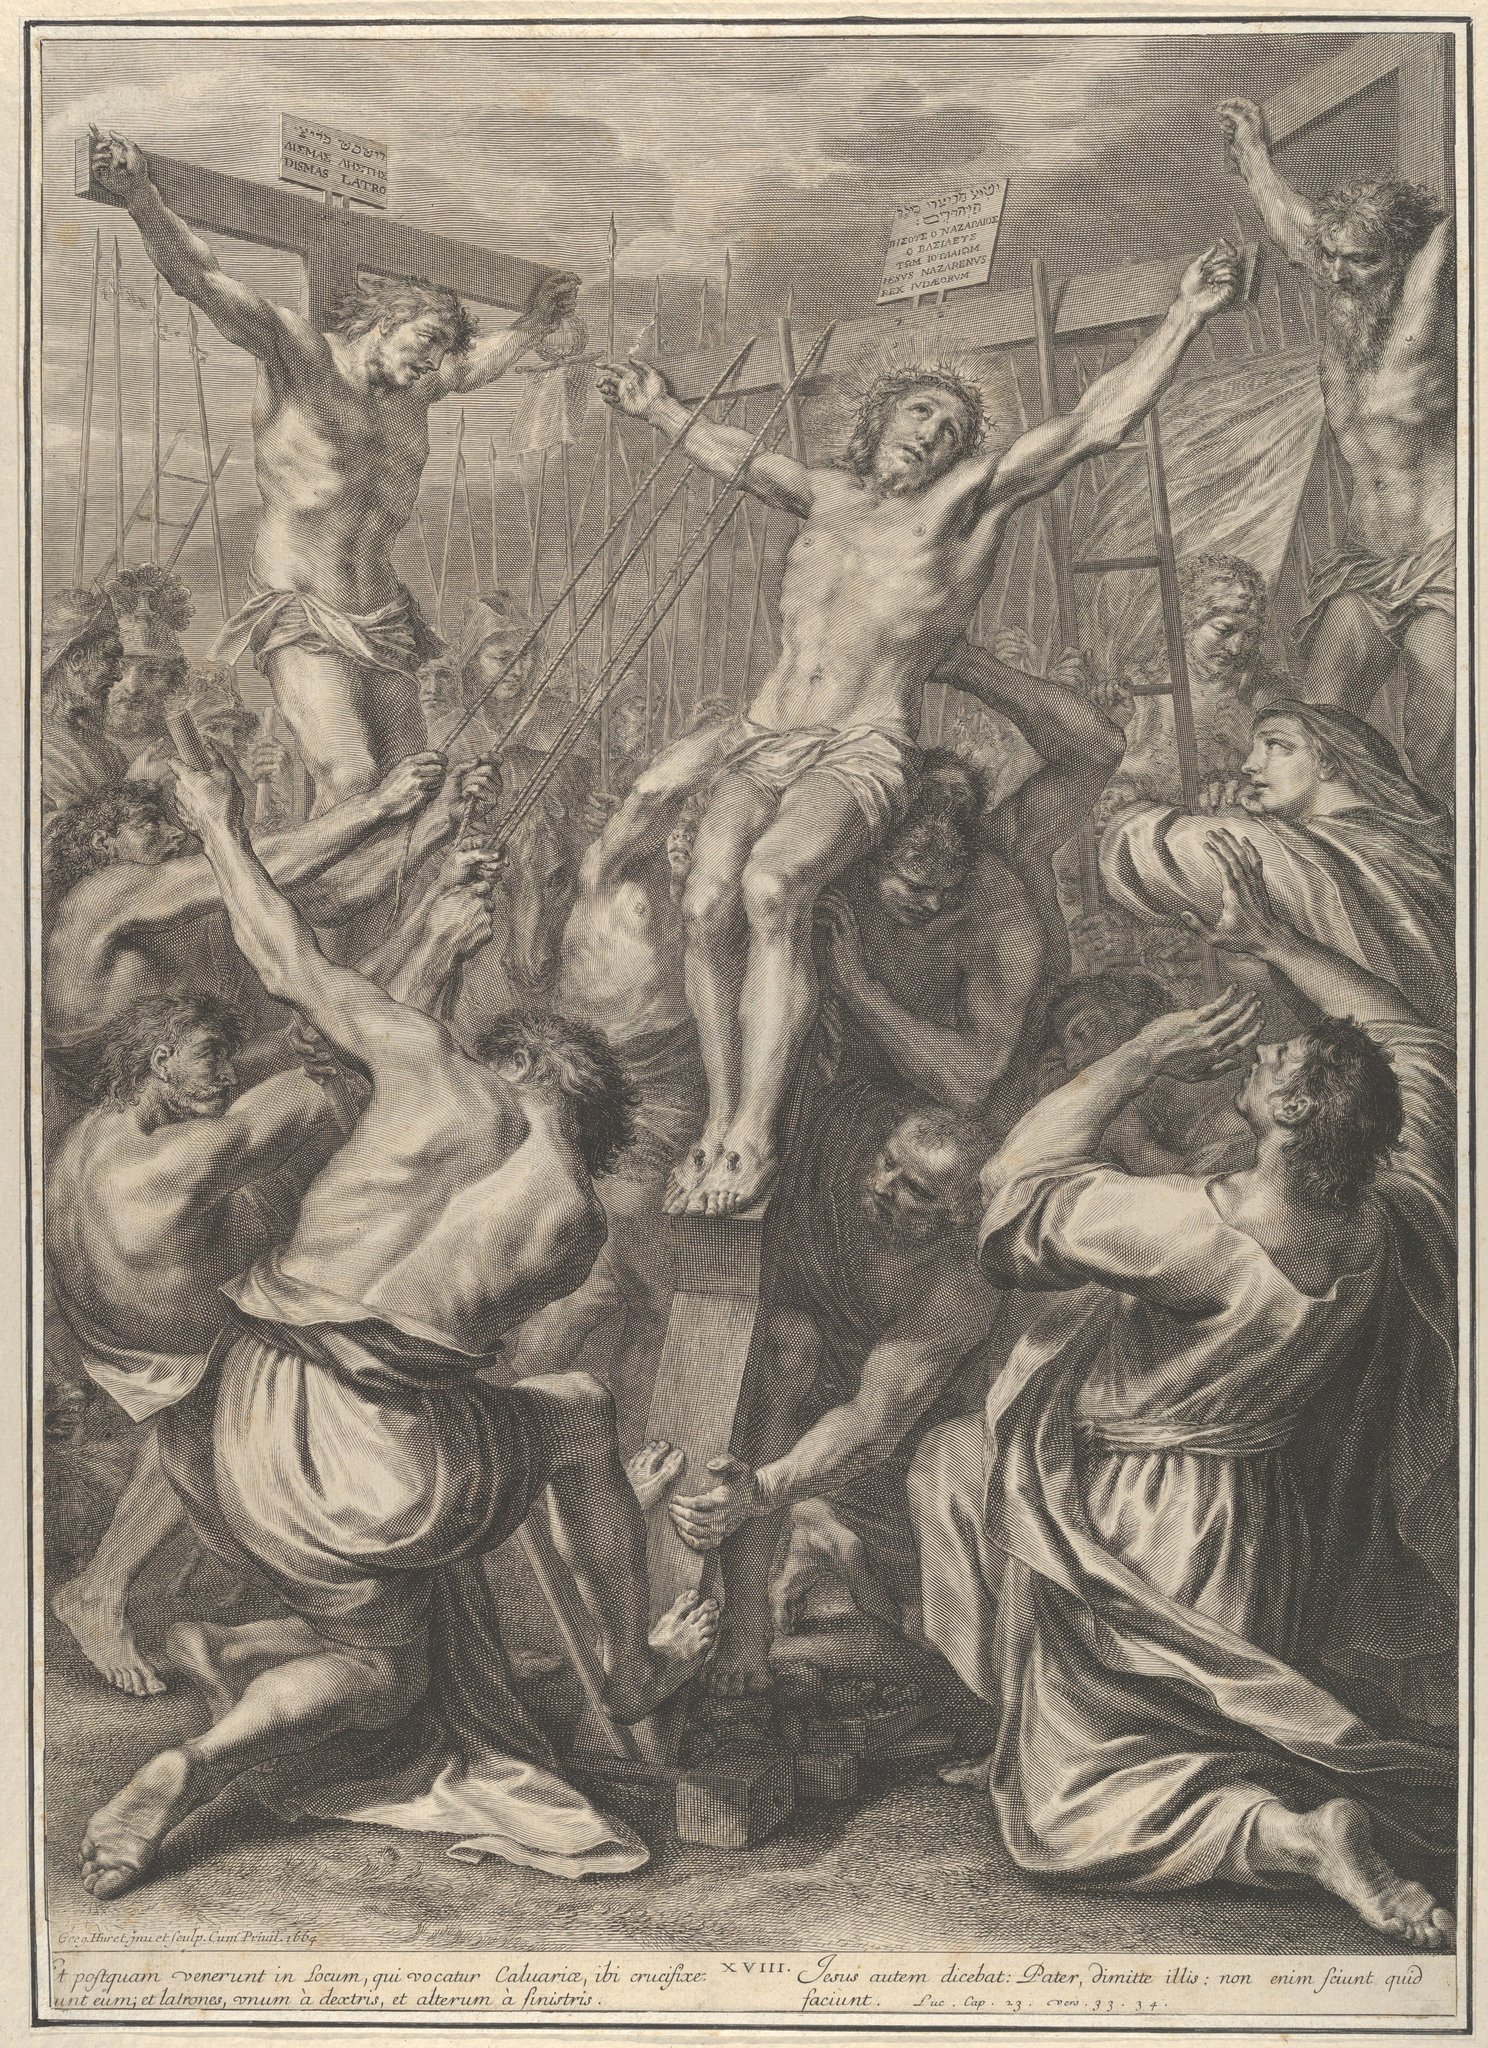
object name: print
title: Christ on Raised on the Cross, from The Passion of Christ, plate 19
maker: grégoire huret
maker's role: artist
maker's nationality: french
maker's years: 1606-1670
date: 1664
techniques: engraving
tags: men,women,christ,crucifixion